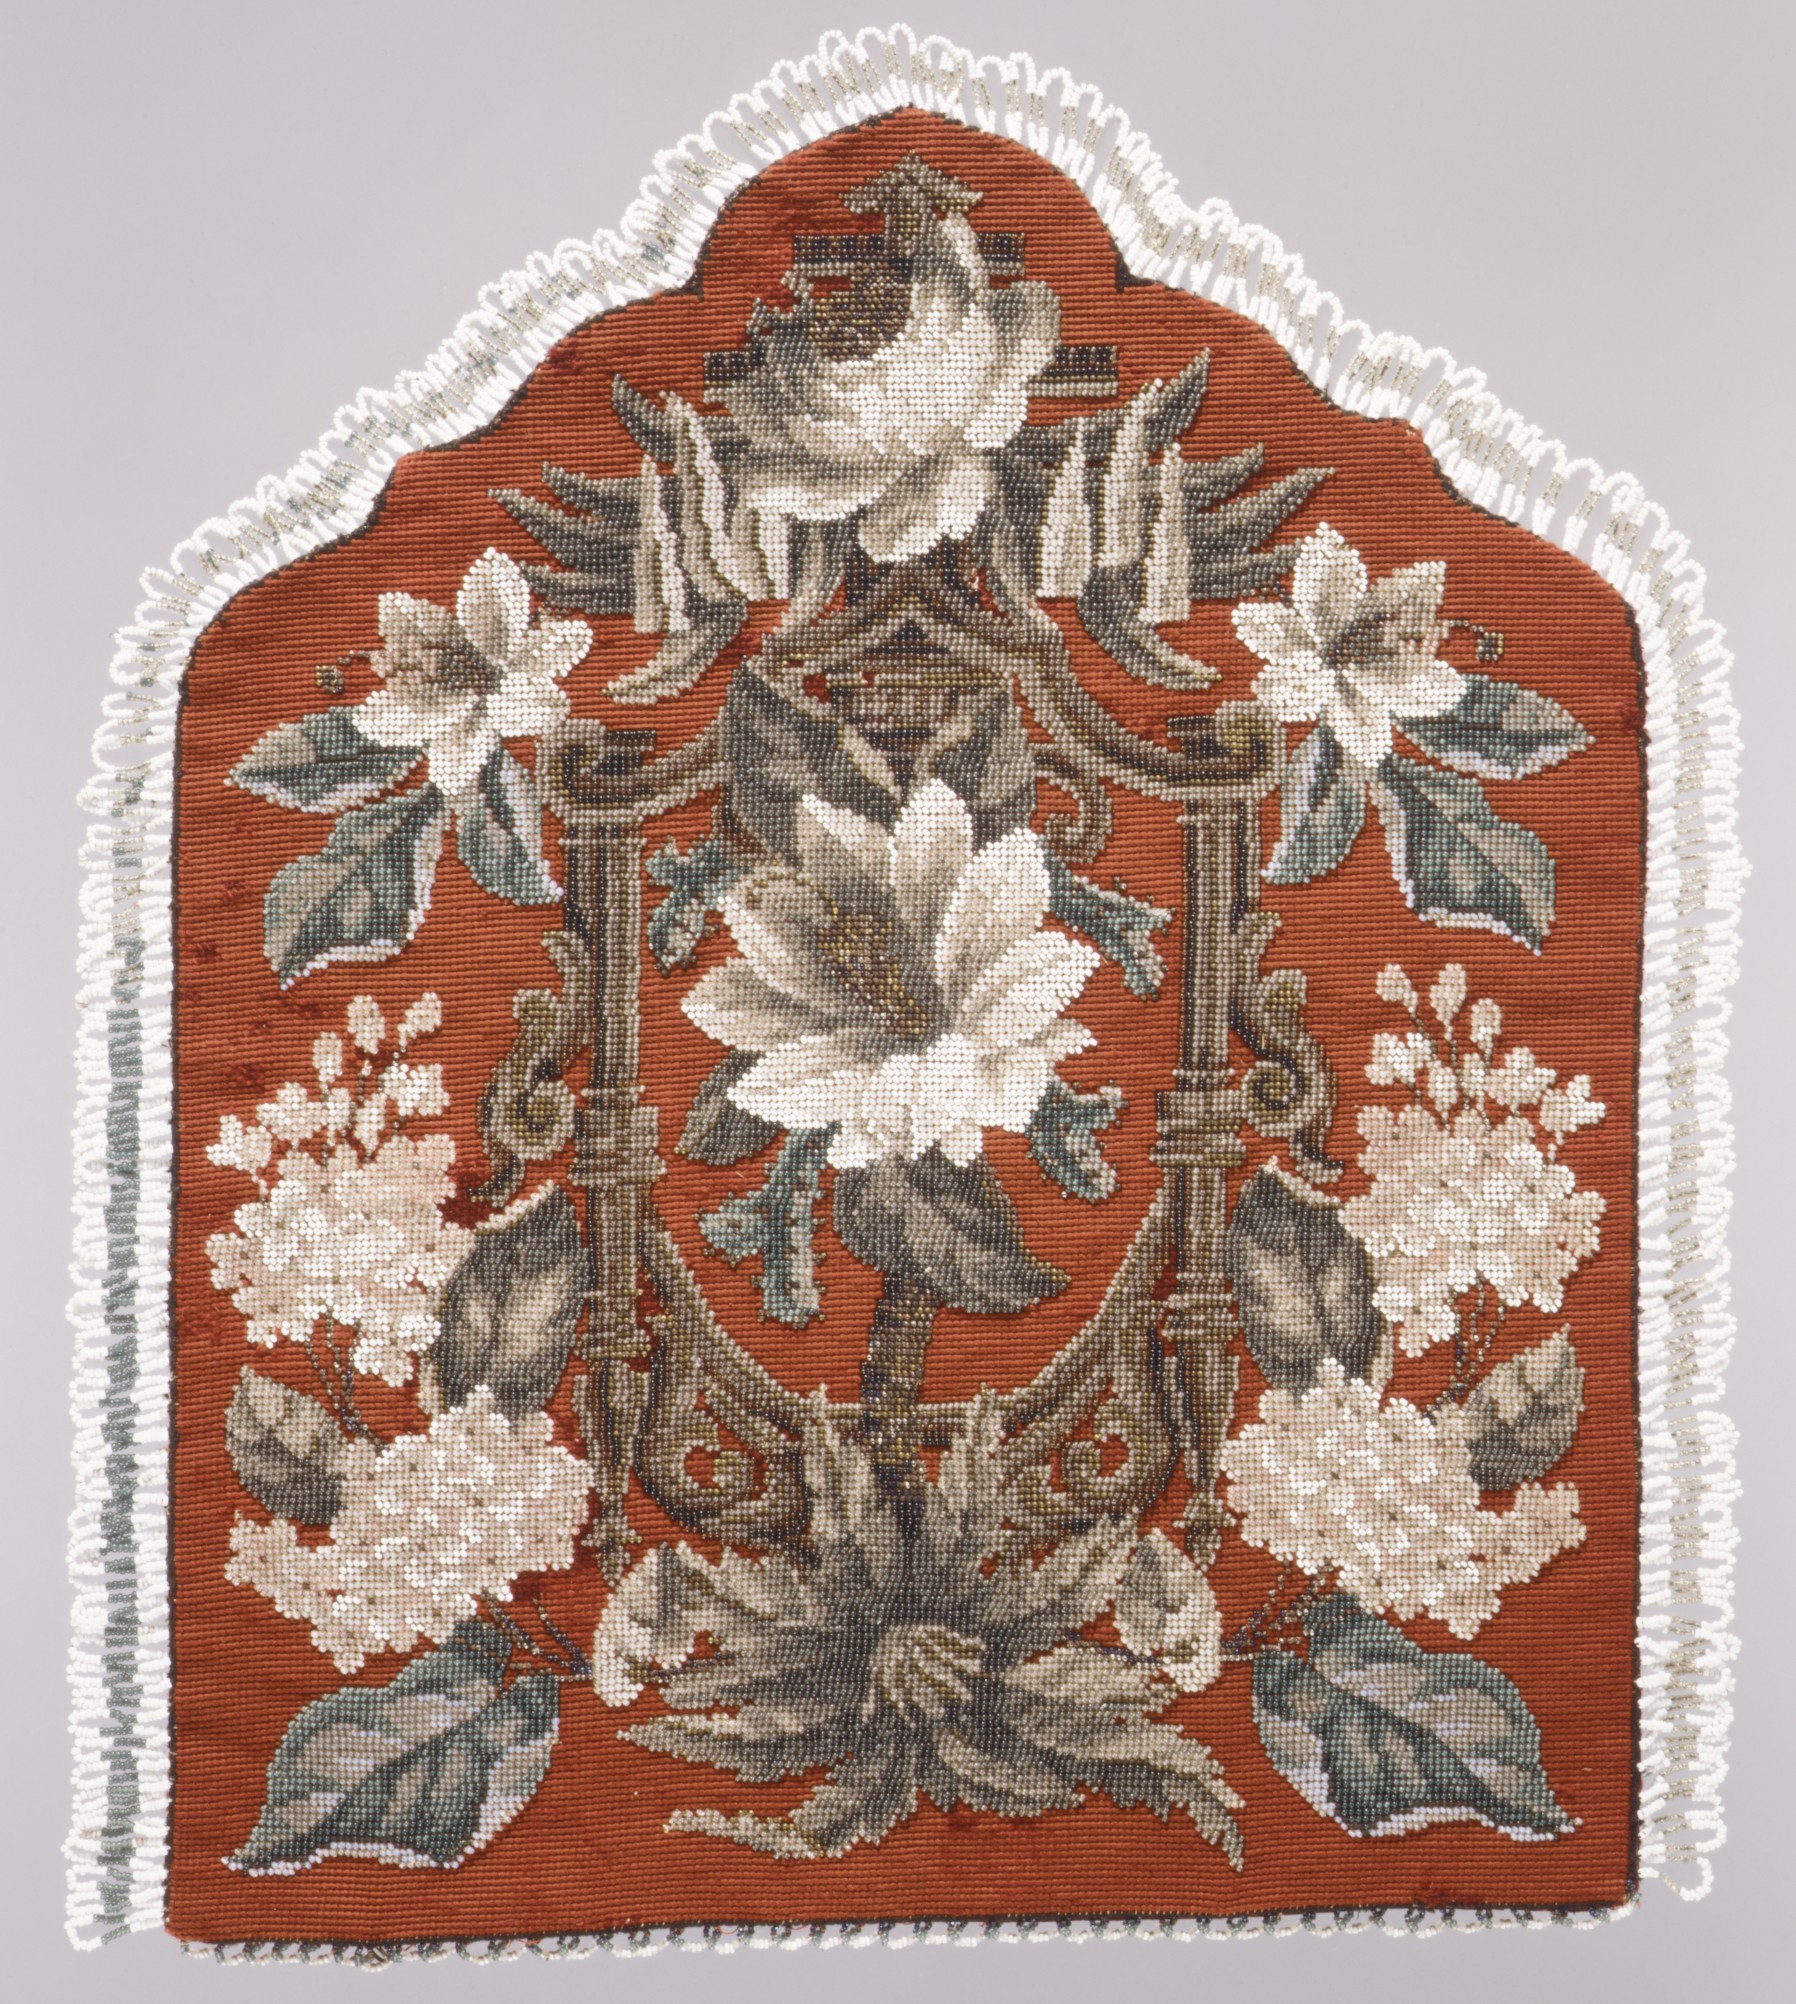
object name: panel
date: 1860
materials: cotton, glass, paste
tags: flowers